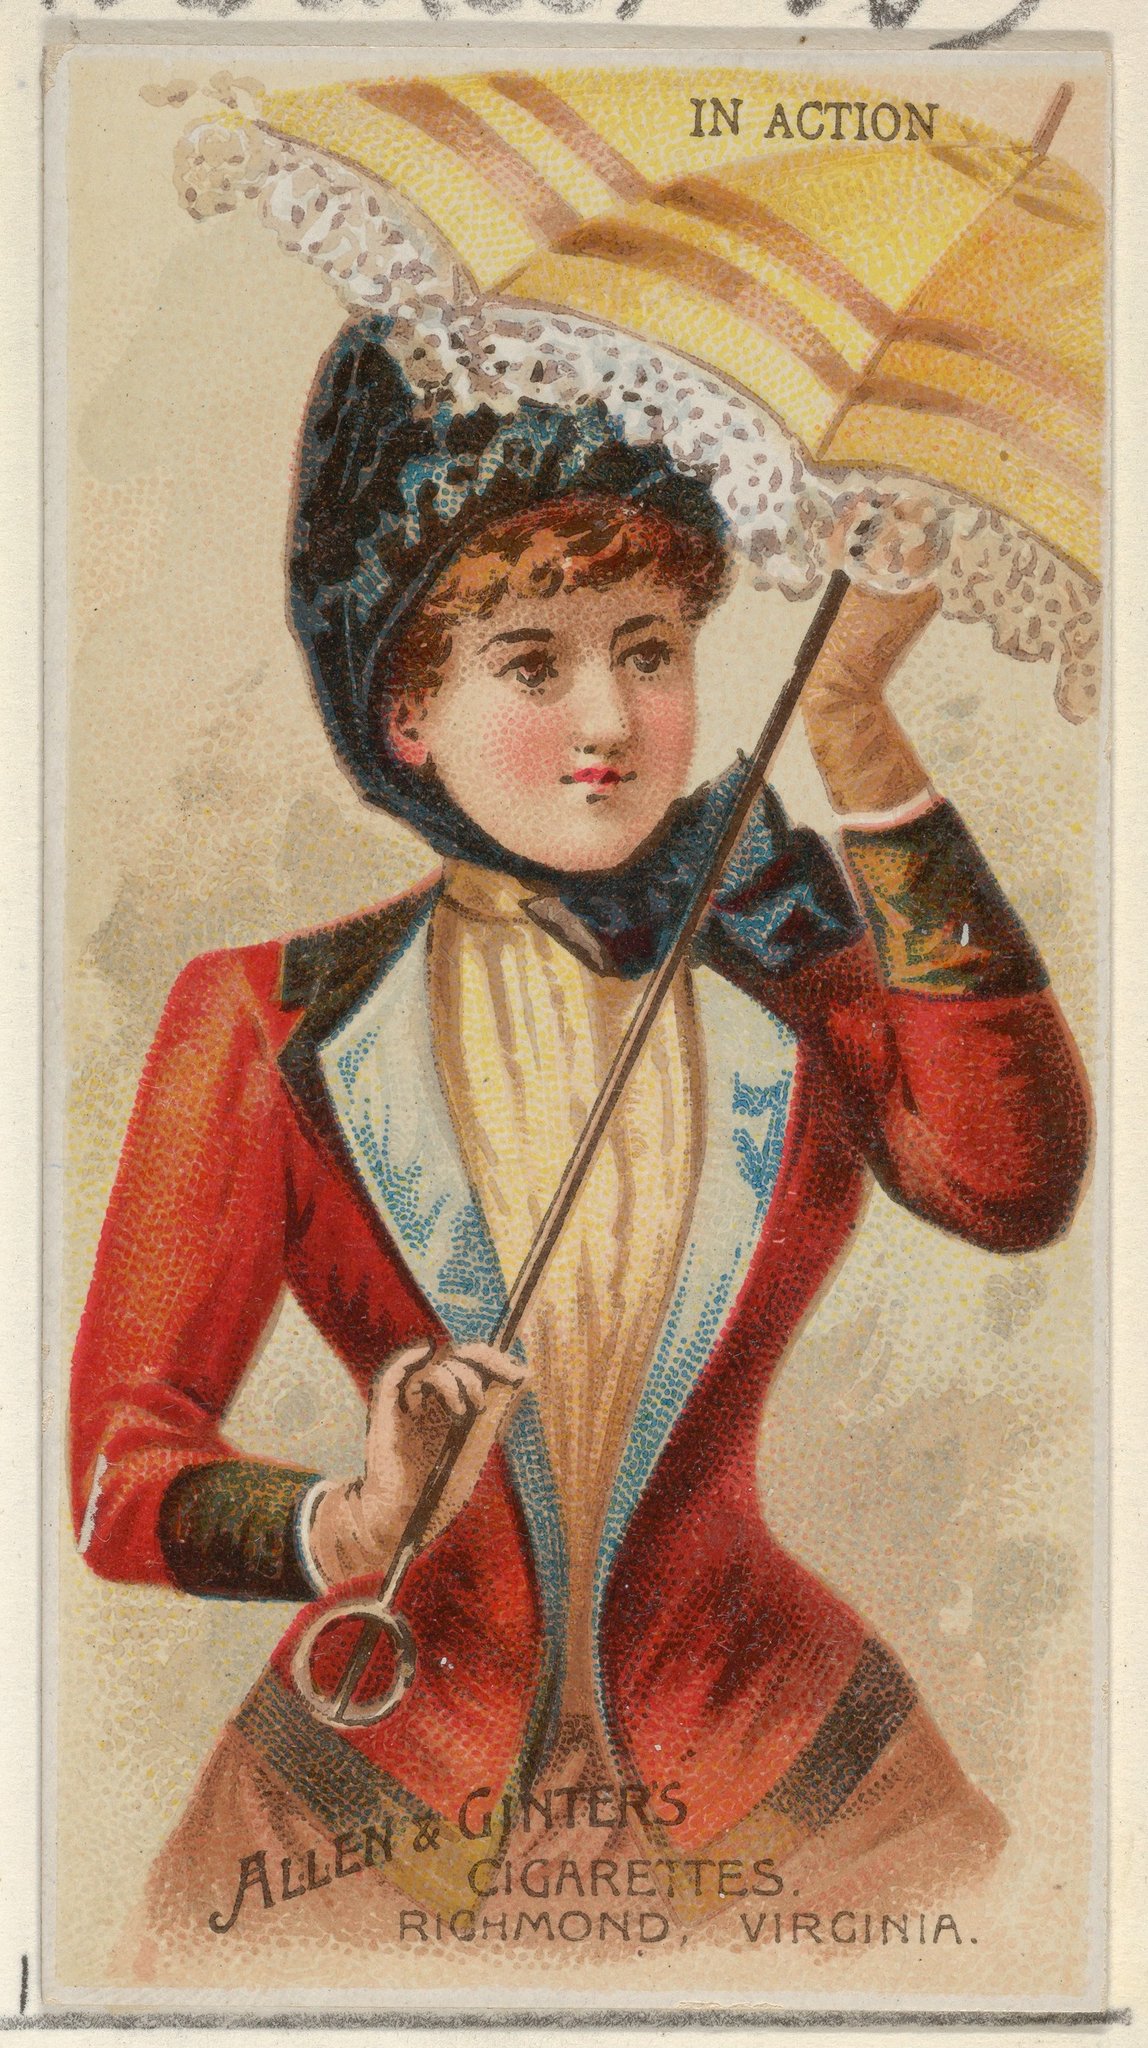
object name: print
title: In Action, from the Parasol Drills series (N18) for Allen & Ginter Cigarettes Brands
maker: allen & ginter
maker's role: publisher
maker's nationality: american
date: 1888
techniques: color lithograph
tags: women